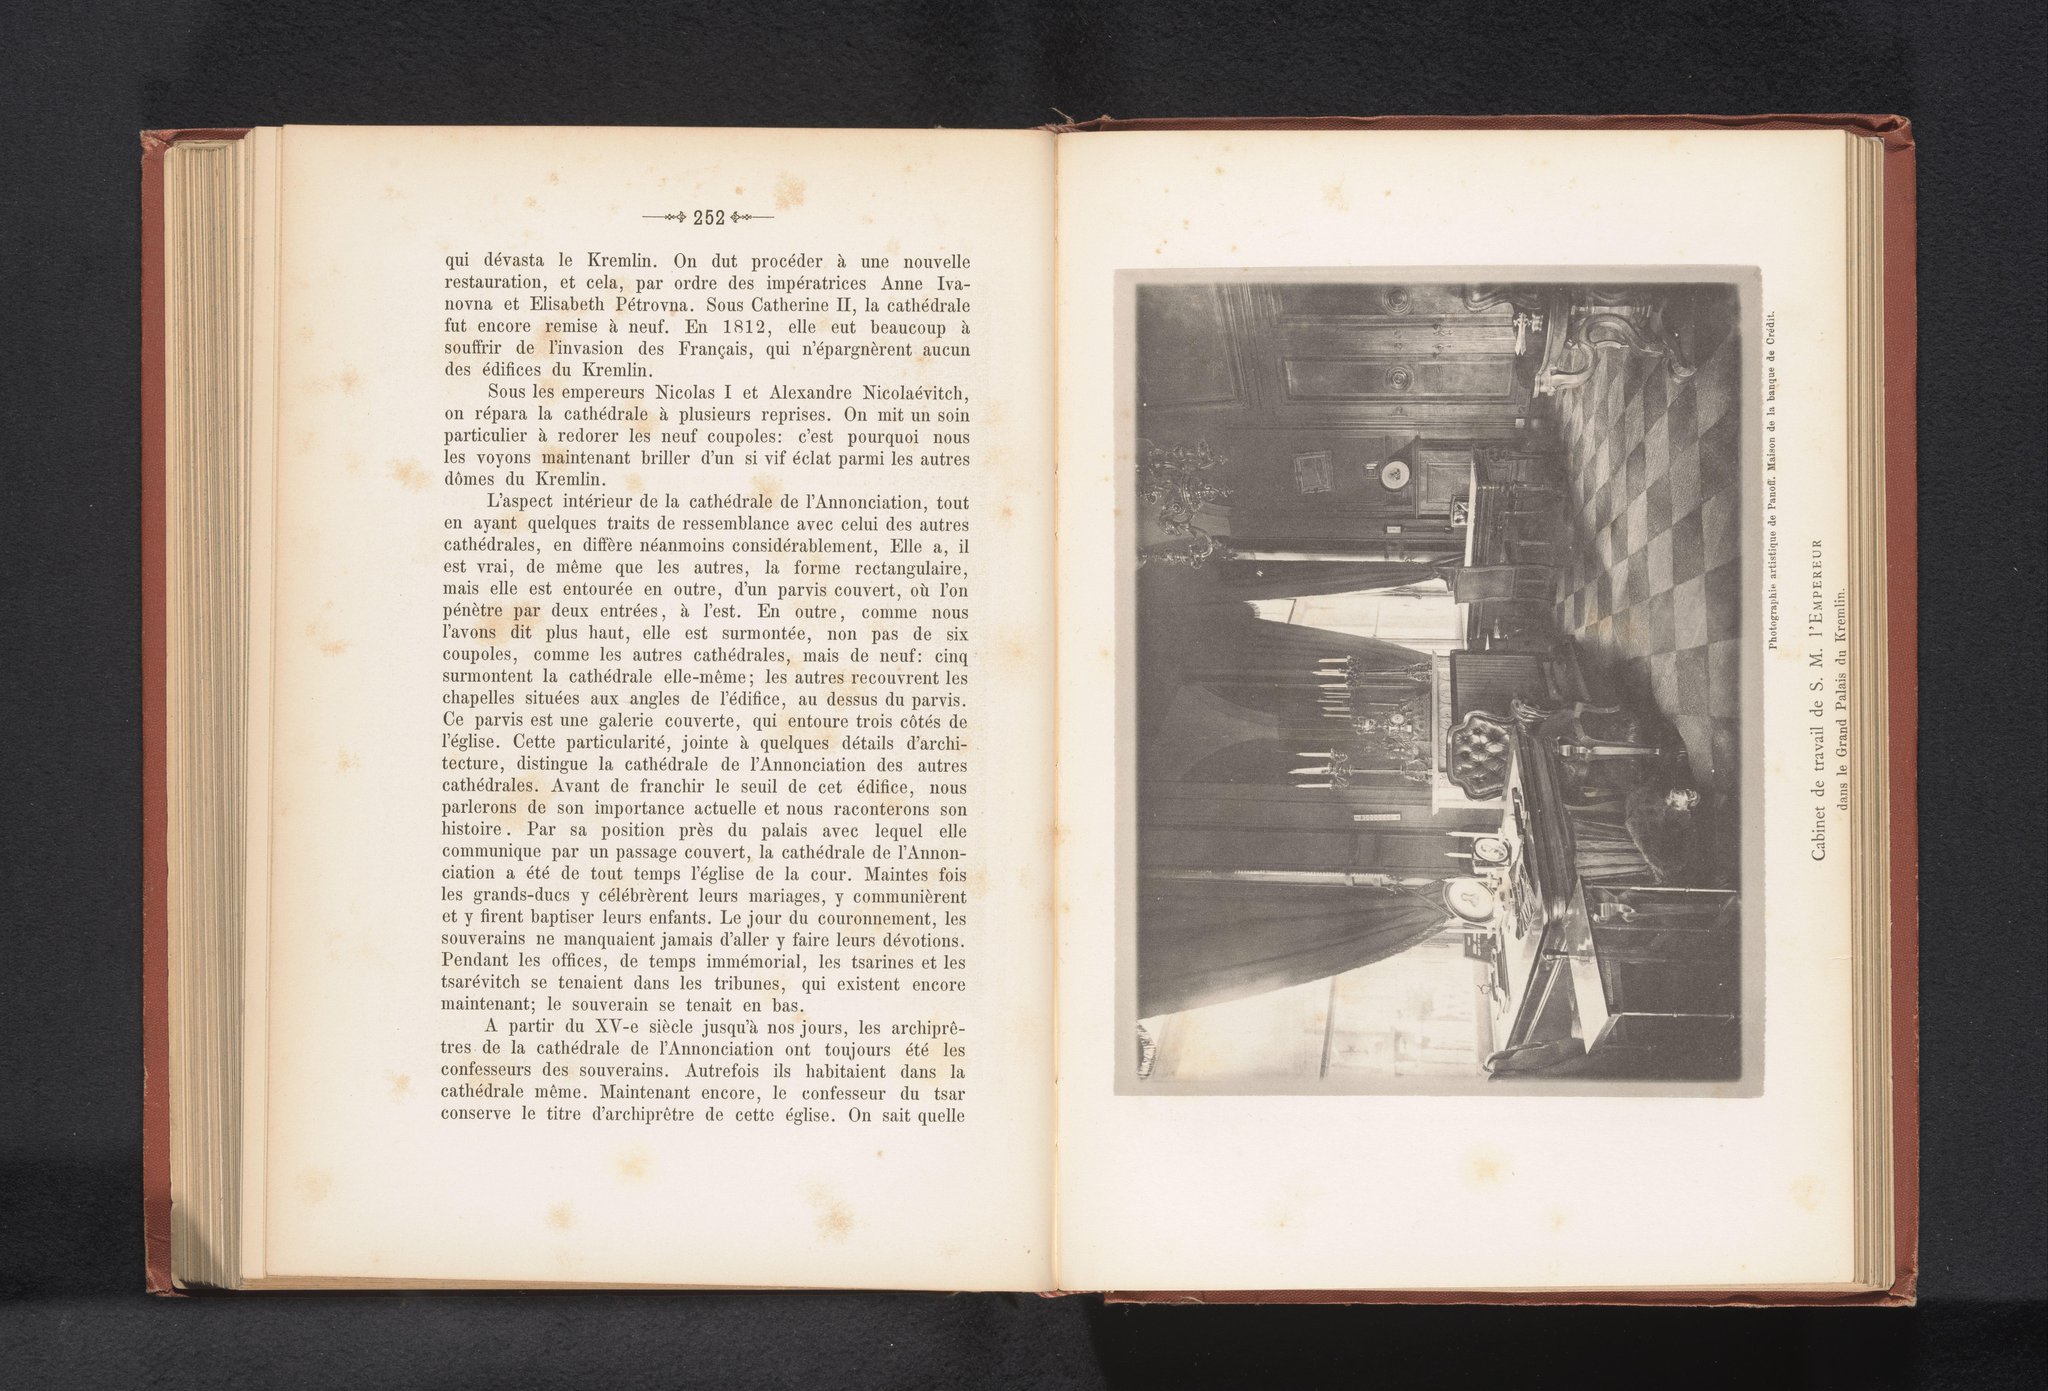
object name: photomechanical print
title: Interieur van een werkkamer van een tsaar in het Grote Kremlinpaleis in het Kremlin van Moskou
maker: Anonymous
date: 1873-1883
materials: paper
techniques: photograph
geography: kremlin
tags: interior of the house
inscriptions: name: ‘Photographie artistique de Panoff. Maison de la banque de Crédit.’